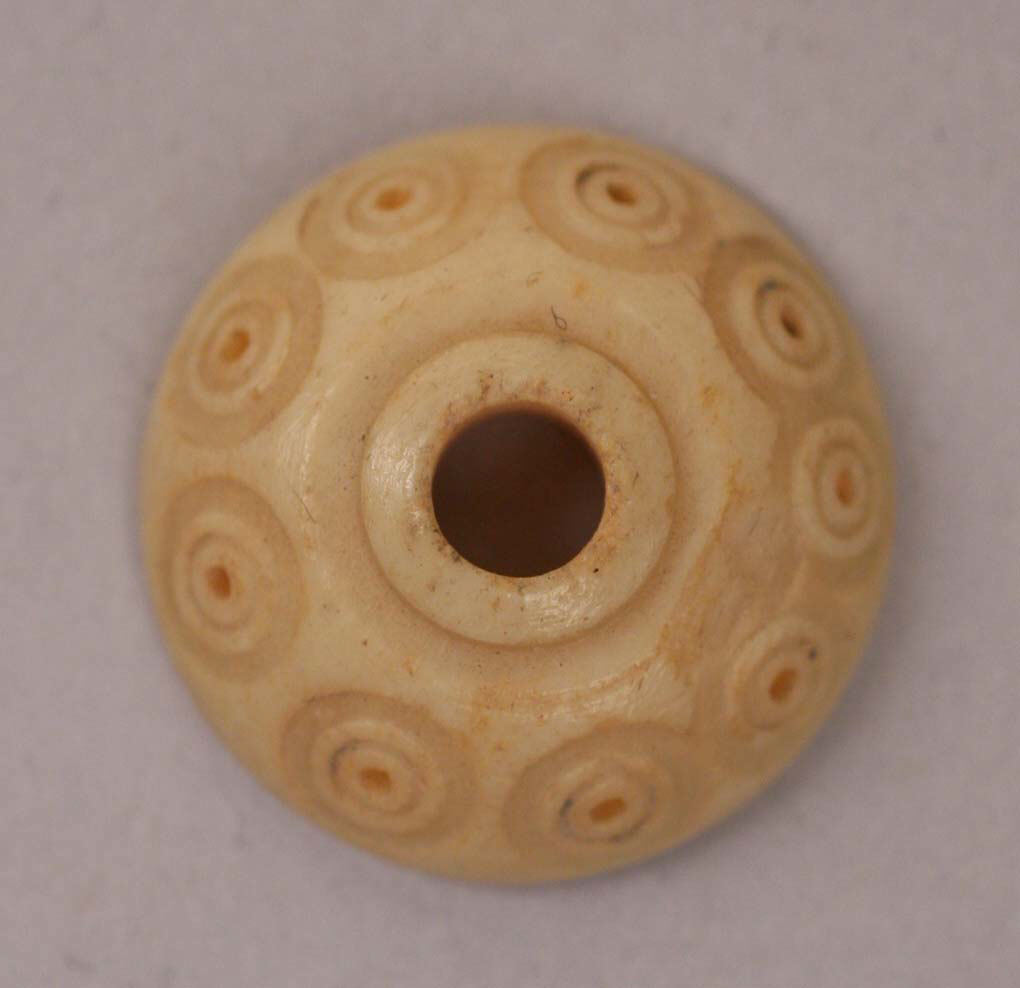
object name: button or bead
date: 801-1000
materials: bone, paint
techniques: incising, inlay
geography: iran